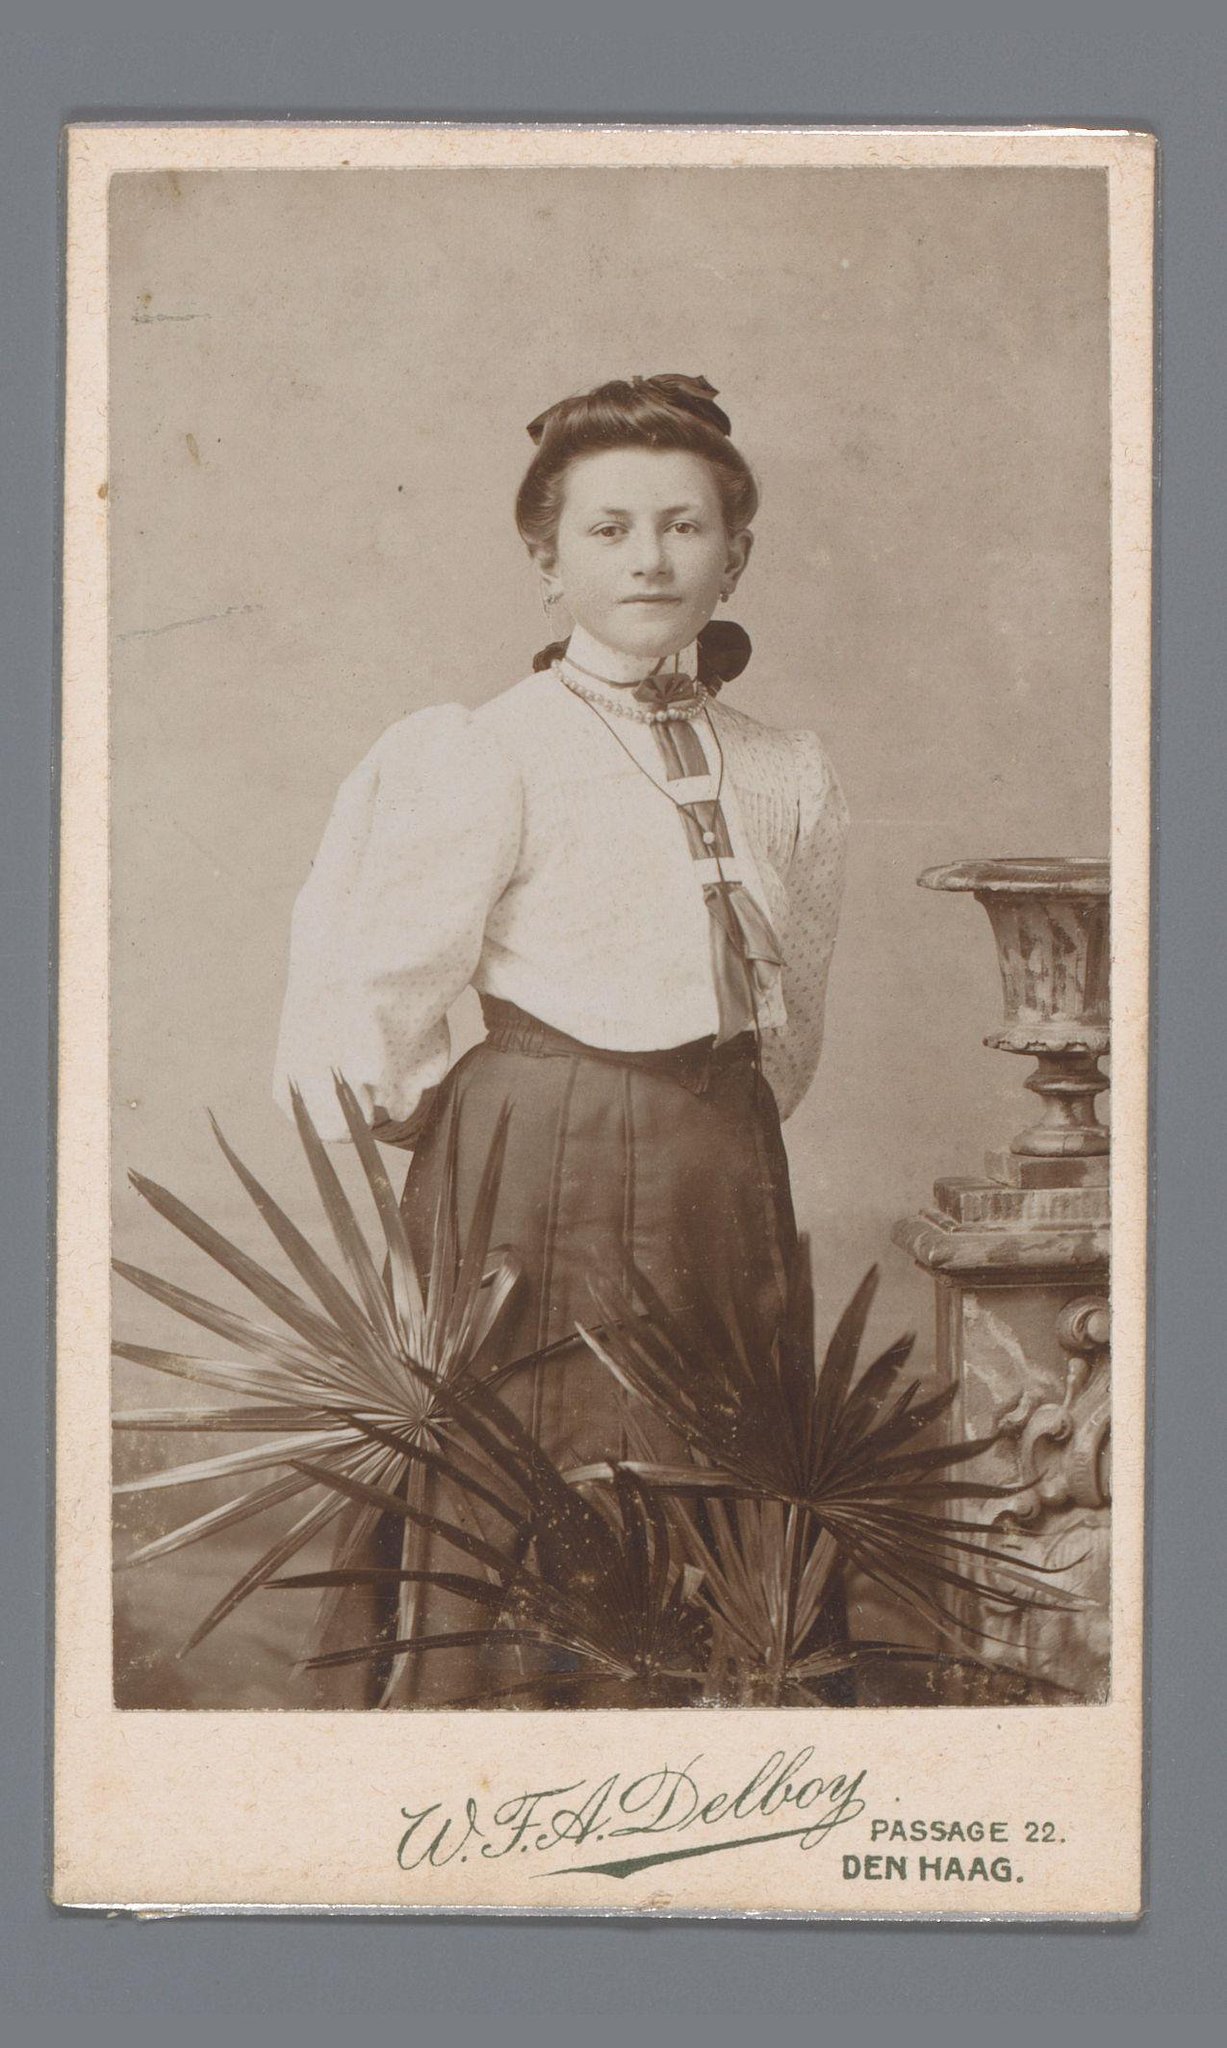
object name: carte de visite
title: Portret van een onbekende jonge vrouw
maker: wilhelm frederick antonius delboy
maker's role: fotograaf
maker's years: 1853-1928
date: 1887-1914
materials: paper, cardboard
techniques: collodion silver print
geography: the hague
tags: adolescent, young woman, maiden, anonymous historical person portrayed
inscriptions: address: ‘PASSAGE 22./ DEN HAAG.’